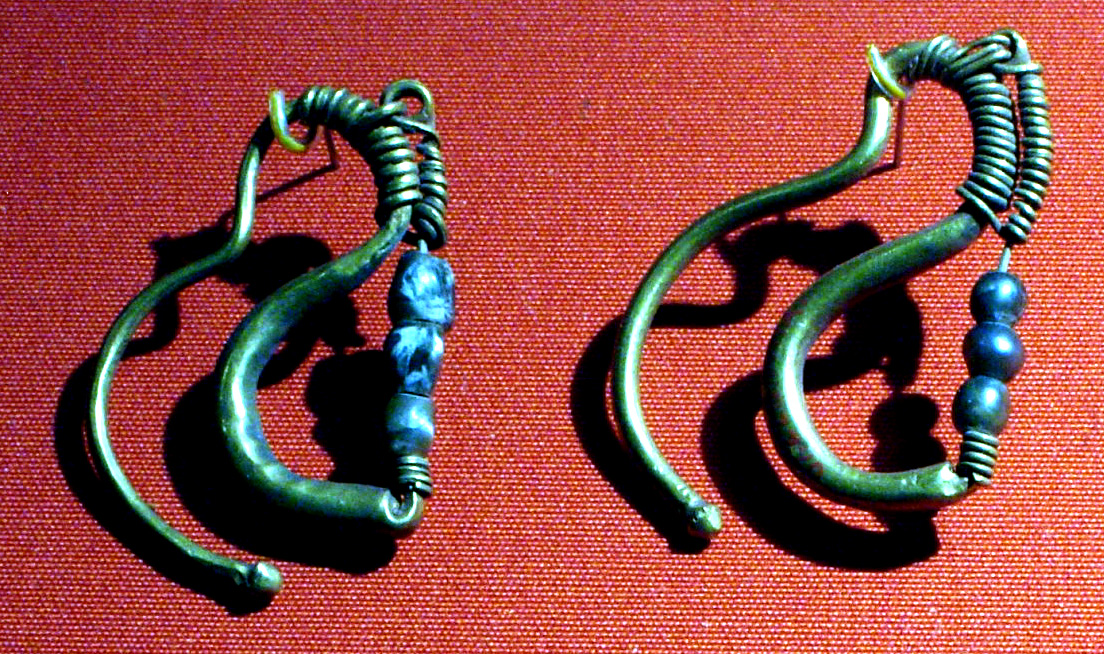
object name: earring, s hoop, pearl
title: S-hoop earrings with pearls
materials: gold, pearl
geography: egypt